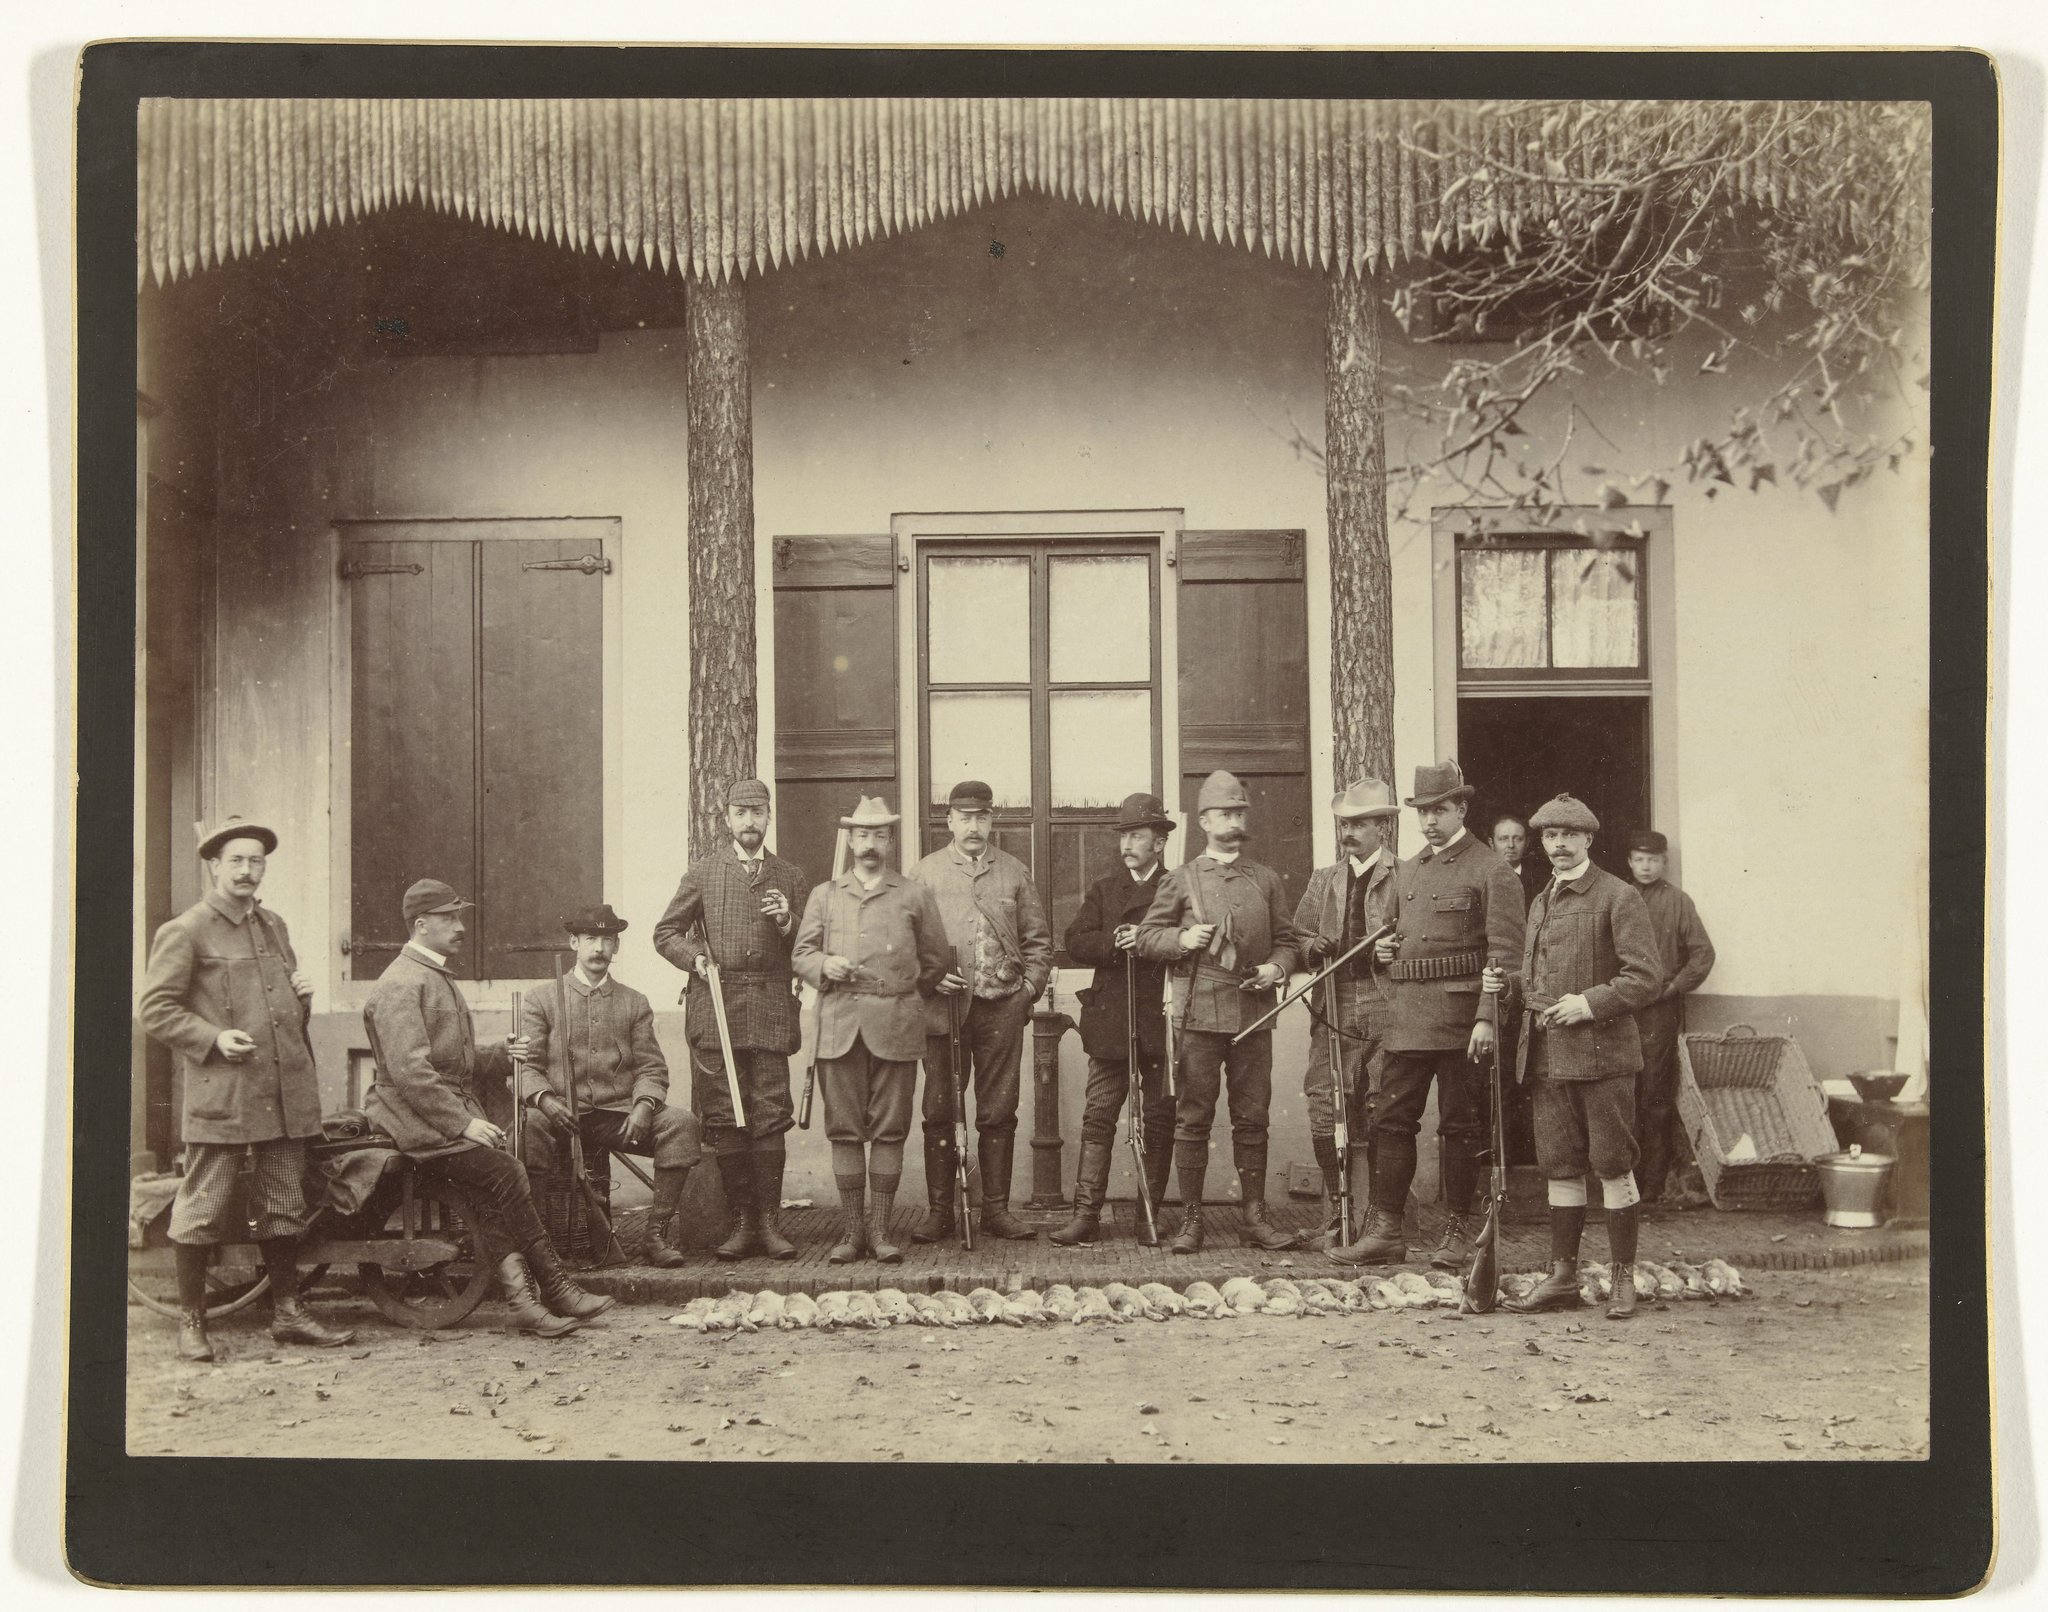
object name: photograph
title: Groepsportret van jagers en helpers, o.a. Henry Pauw van Wieldrecht en Maarten Pauw van Wieldrecht, met het geschoten wild aan hun voeten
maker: henry pauw van wieldrecht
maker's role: fotograaf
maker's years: 1863-1912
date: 1891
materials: cardboard, photographic support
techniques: albumen print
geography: netherlands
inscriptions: annotation: ‘No 118. 463. 1891.’